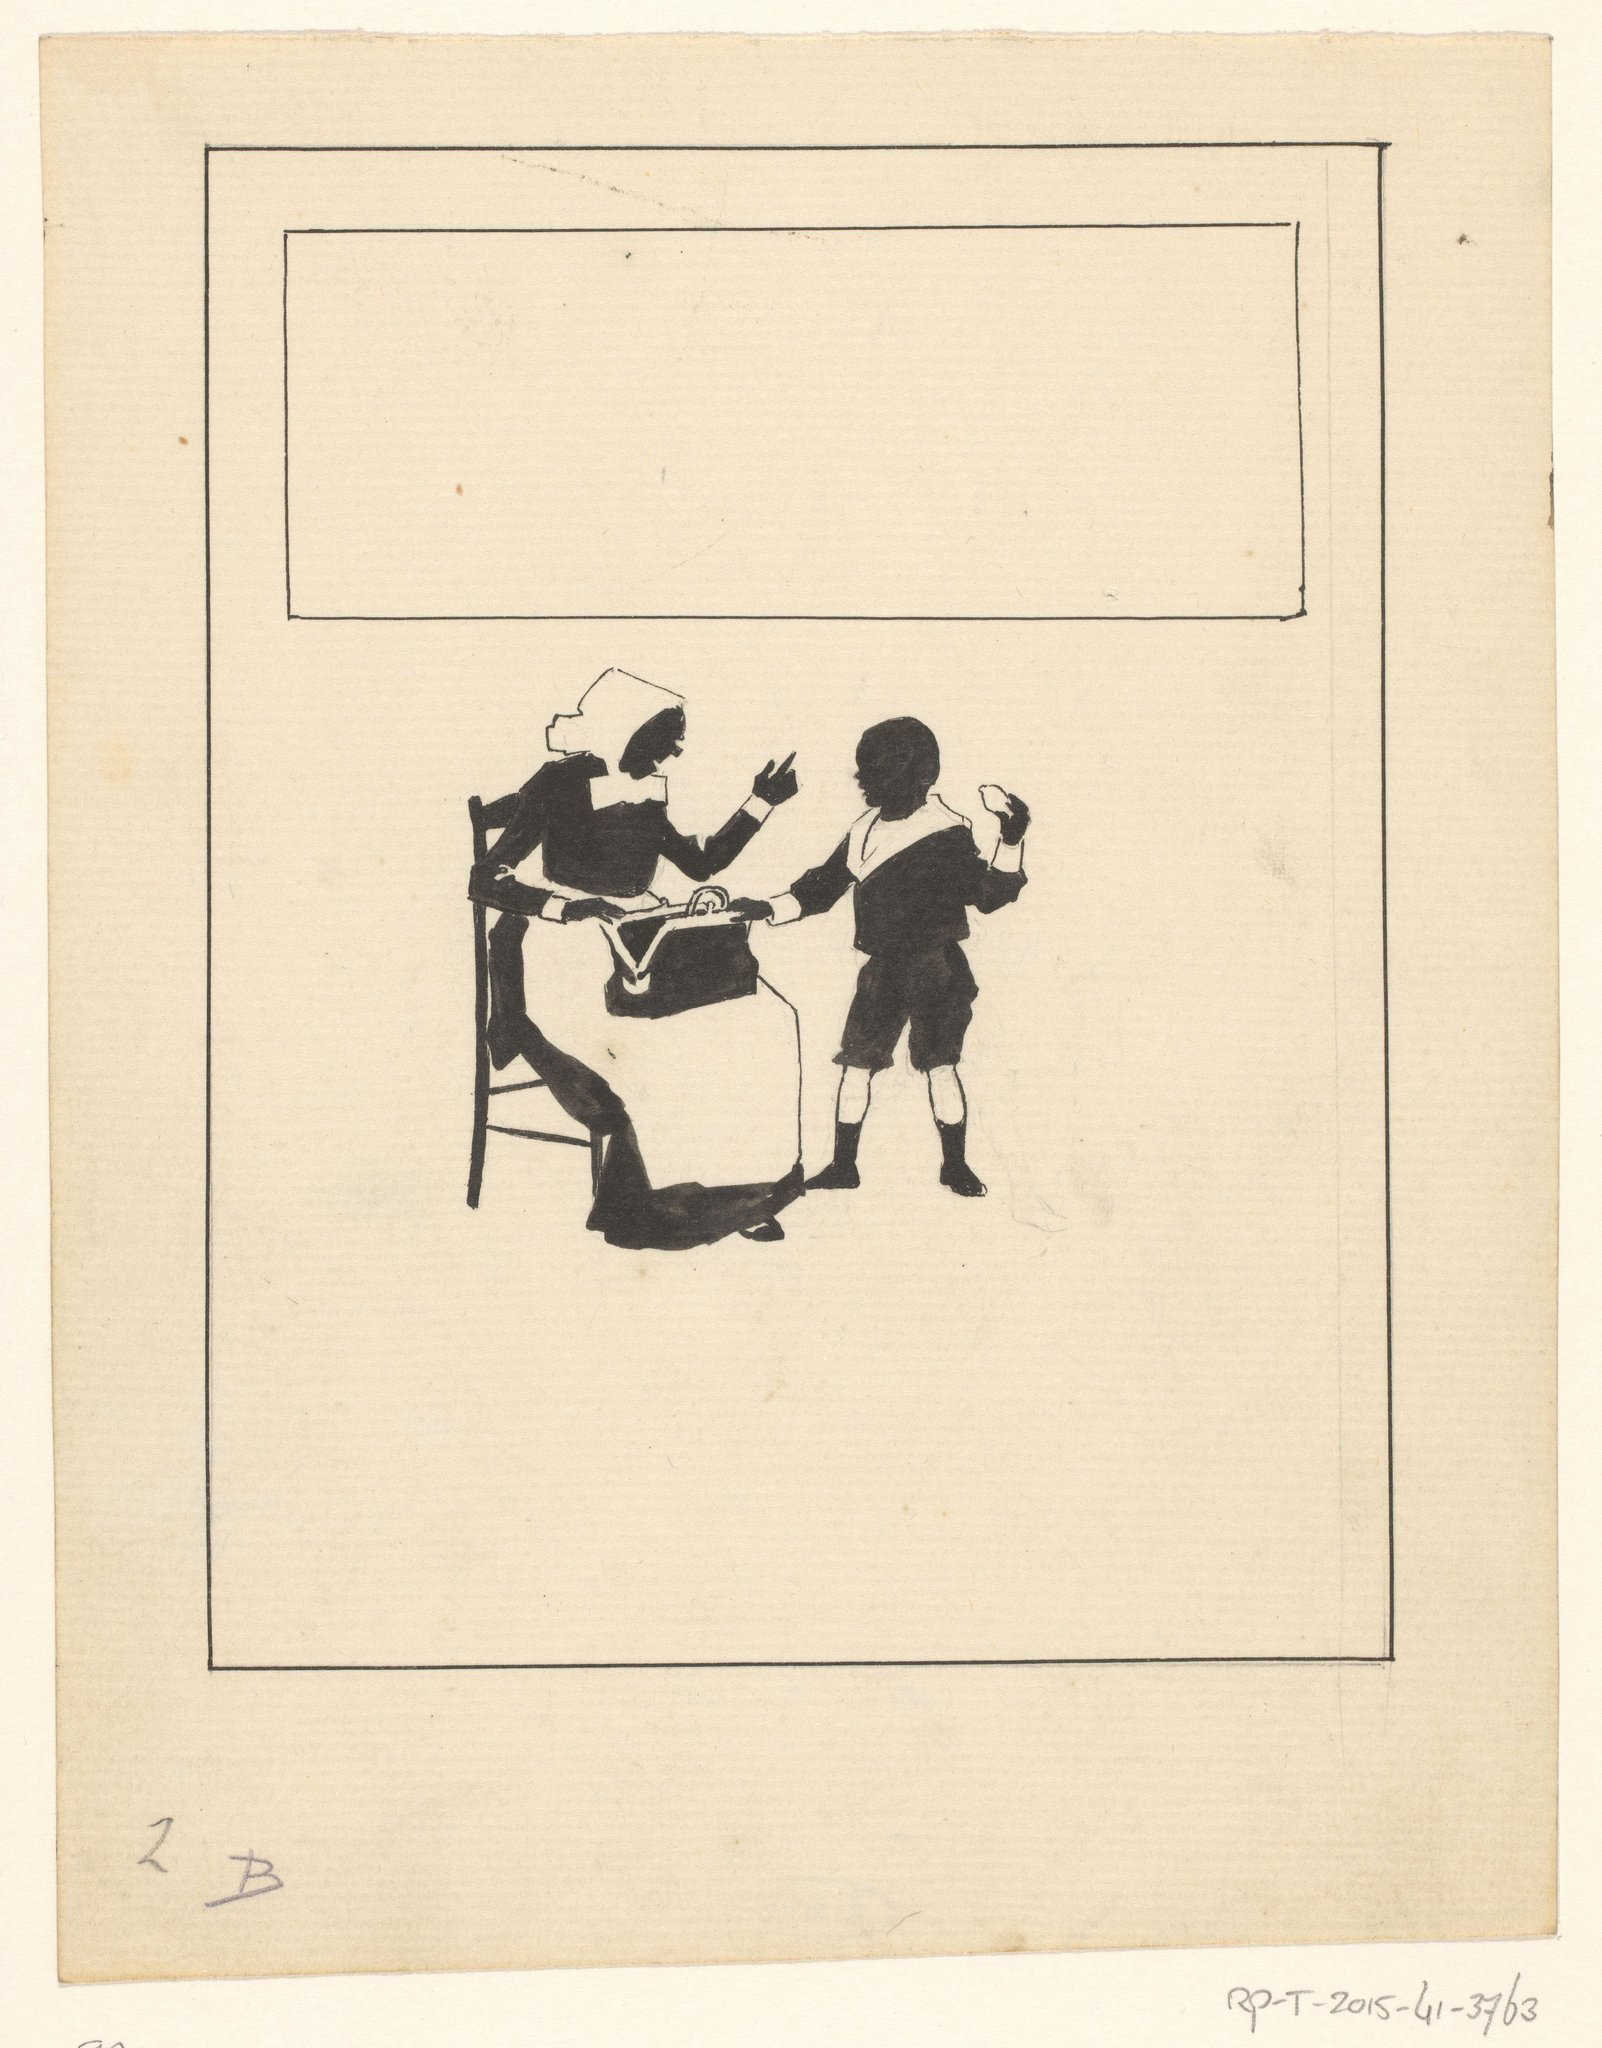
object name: boekillustratie ontwerp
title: Vrouw en jongen met een tas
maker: Anonymous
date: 1880-1910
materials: ink, paper, pencil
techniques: brush, pen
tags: bag, fruits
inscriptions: collector's mark: Lugt 2228a, number: ‘2B’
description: Een jongen pakt een voorwerp, vermoedelijk een stuk fruit, uit de tas van een zittende vrouw.